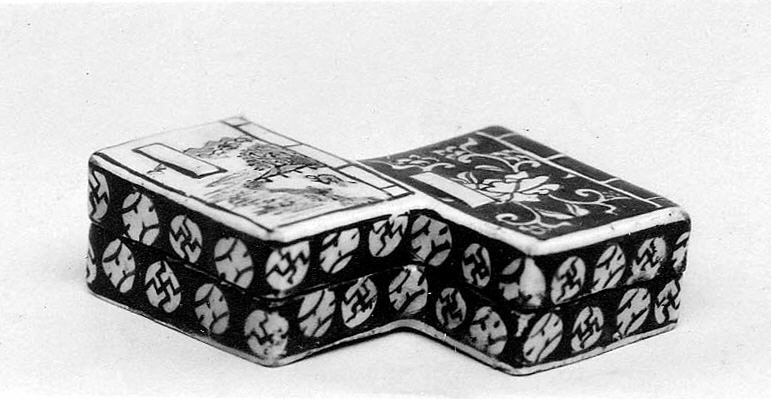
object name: incense box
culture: japanese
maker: yusetsu banko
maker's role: artist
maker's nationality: japanese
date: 1840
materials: faience